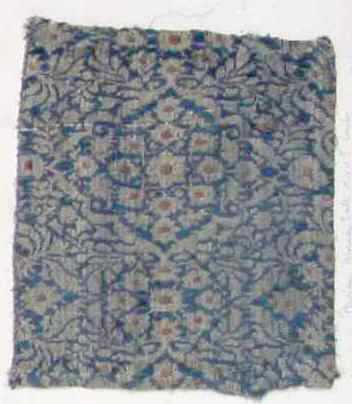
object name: textile fragment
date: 1601-1800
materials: silk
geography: turkey